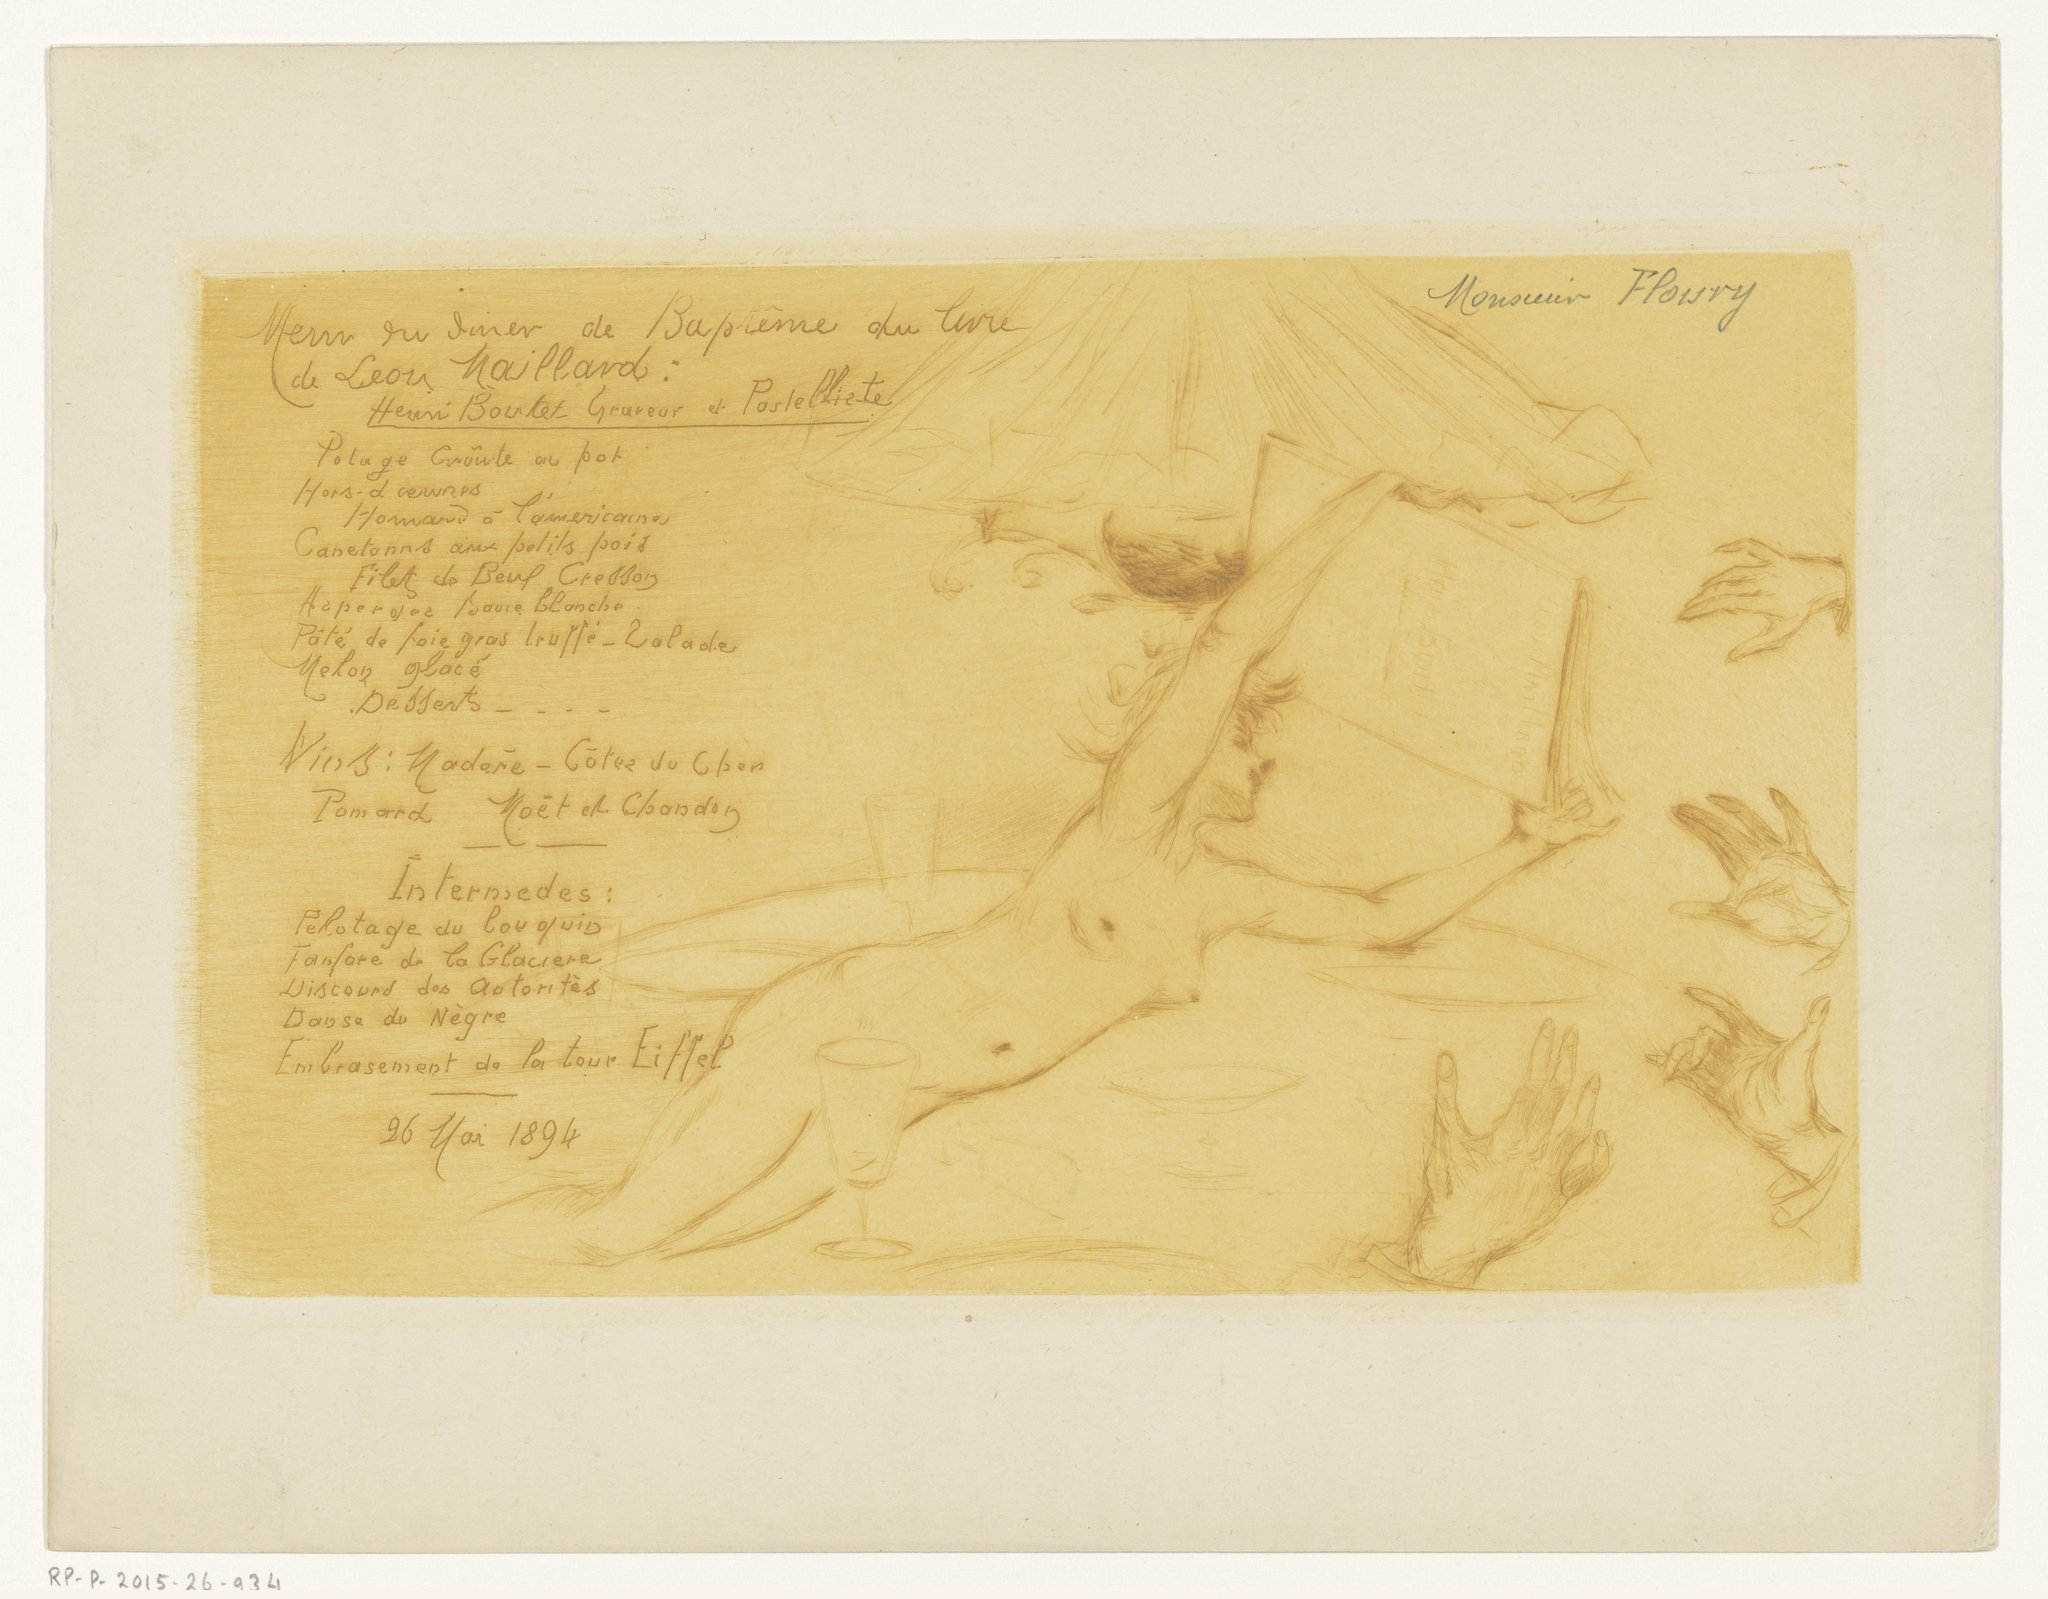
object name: menu, menukaart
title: Menu voor het diner ter ere van de publicatie van het boek 'Henri Boutet graveur et pastelliste' door Leon Maillard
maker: henri boutet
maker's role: draughtsman, print maker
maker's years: 1851-1919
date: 1805-1894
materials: paper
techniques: drypoint, intaglio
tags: book, evening meal, dinner, supper, the (nude) human figure; 'corpo humano' (ripa) - aa - female human figure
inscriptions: annotation: ‘Monsieur Floury’, collector's mark: Lugt 2228, collector's mark: Lugt 4780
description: Een naakte vrouw vliegt over een tafel met glazen en borden. Uitgestrekte handen reiken naar het boek van Maillard dat zij in haar handen heeft.